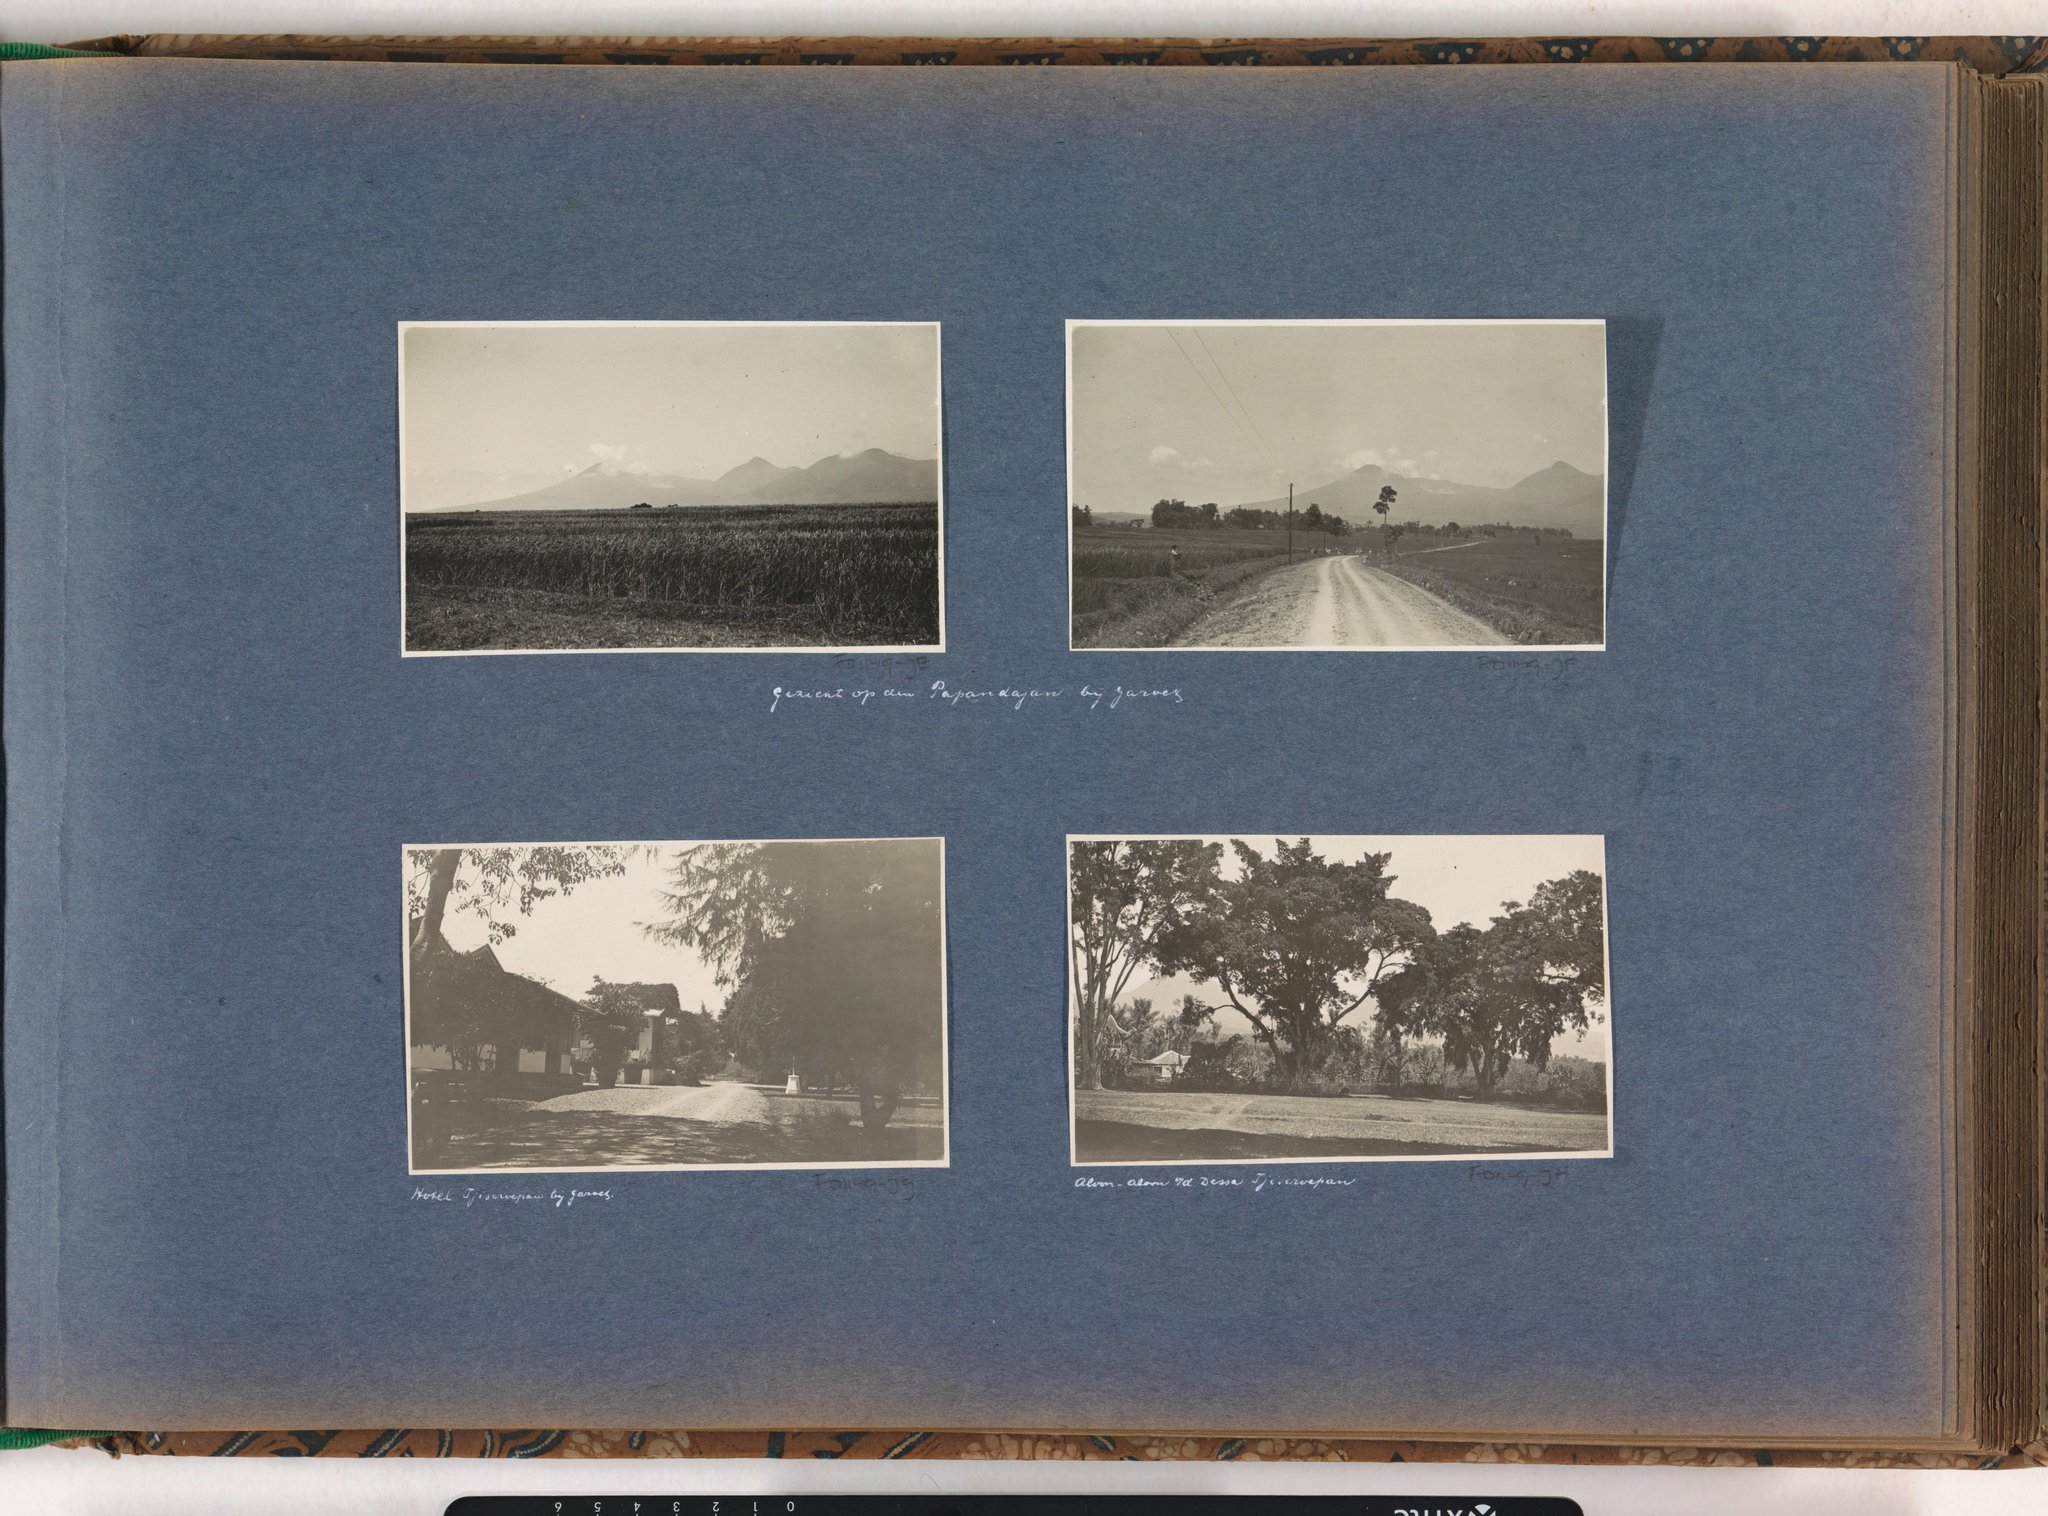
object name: photograph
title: Vulkaan Papandayan bij Garut, gezien over velden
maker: Anonymous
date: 1900-1920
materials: paper, photographic support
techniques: gelatin silver print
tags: field filled with a crop, volcano, java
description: Onderdeel van reisalbum met foto's van bedrijvigheid en bezienswaardigheden op Sumatra en Java en van de reis naar en van Nederlands-Indië.